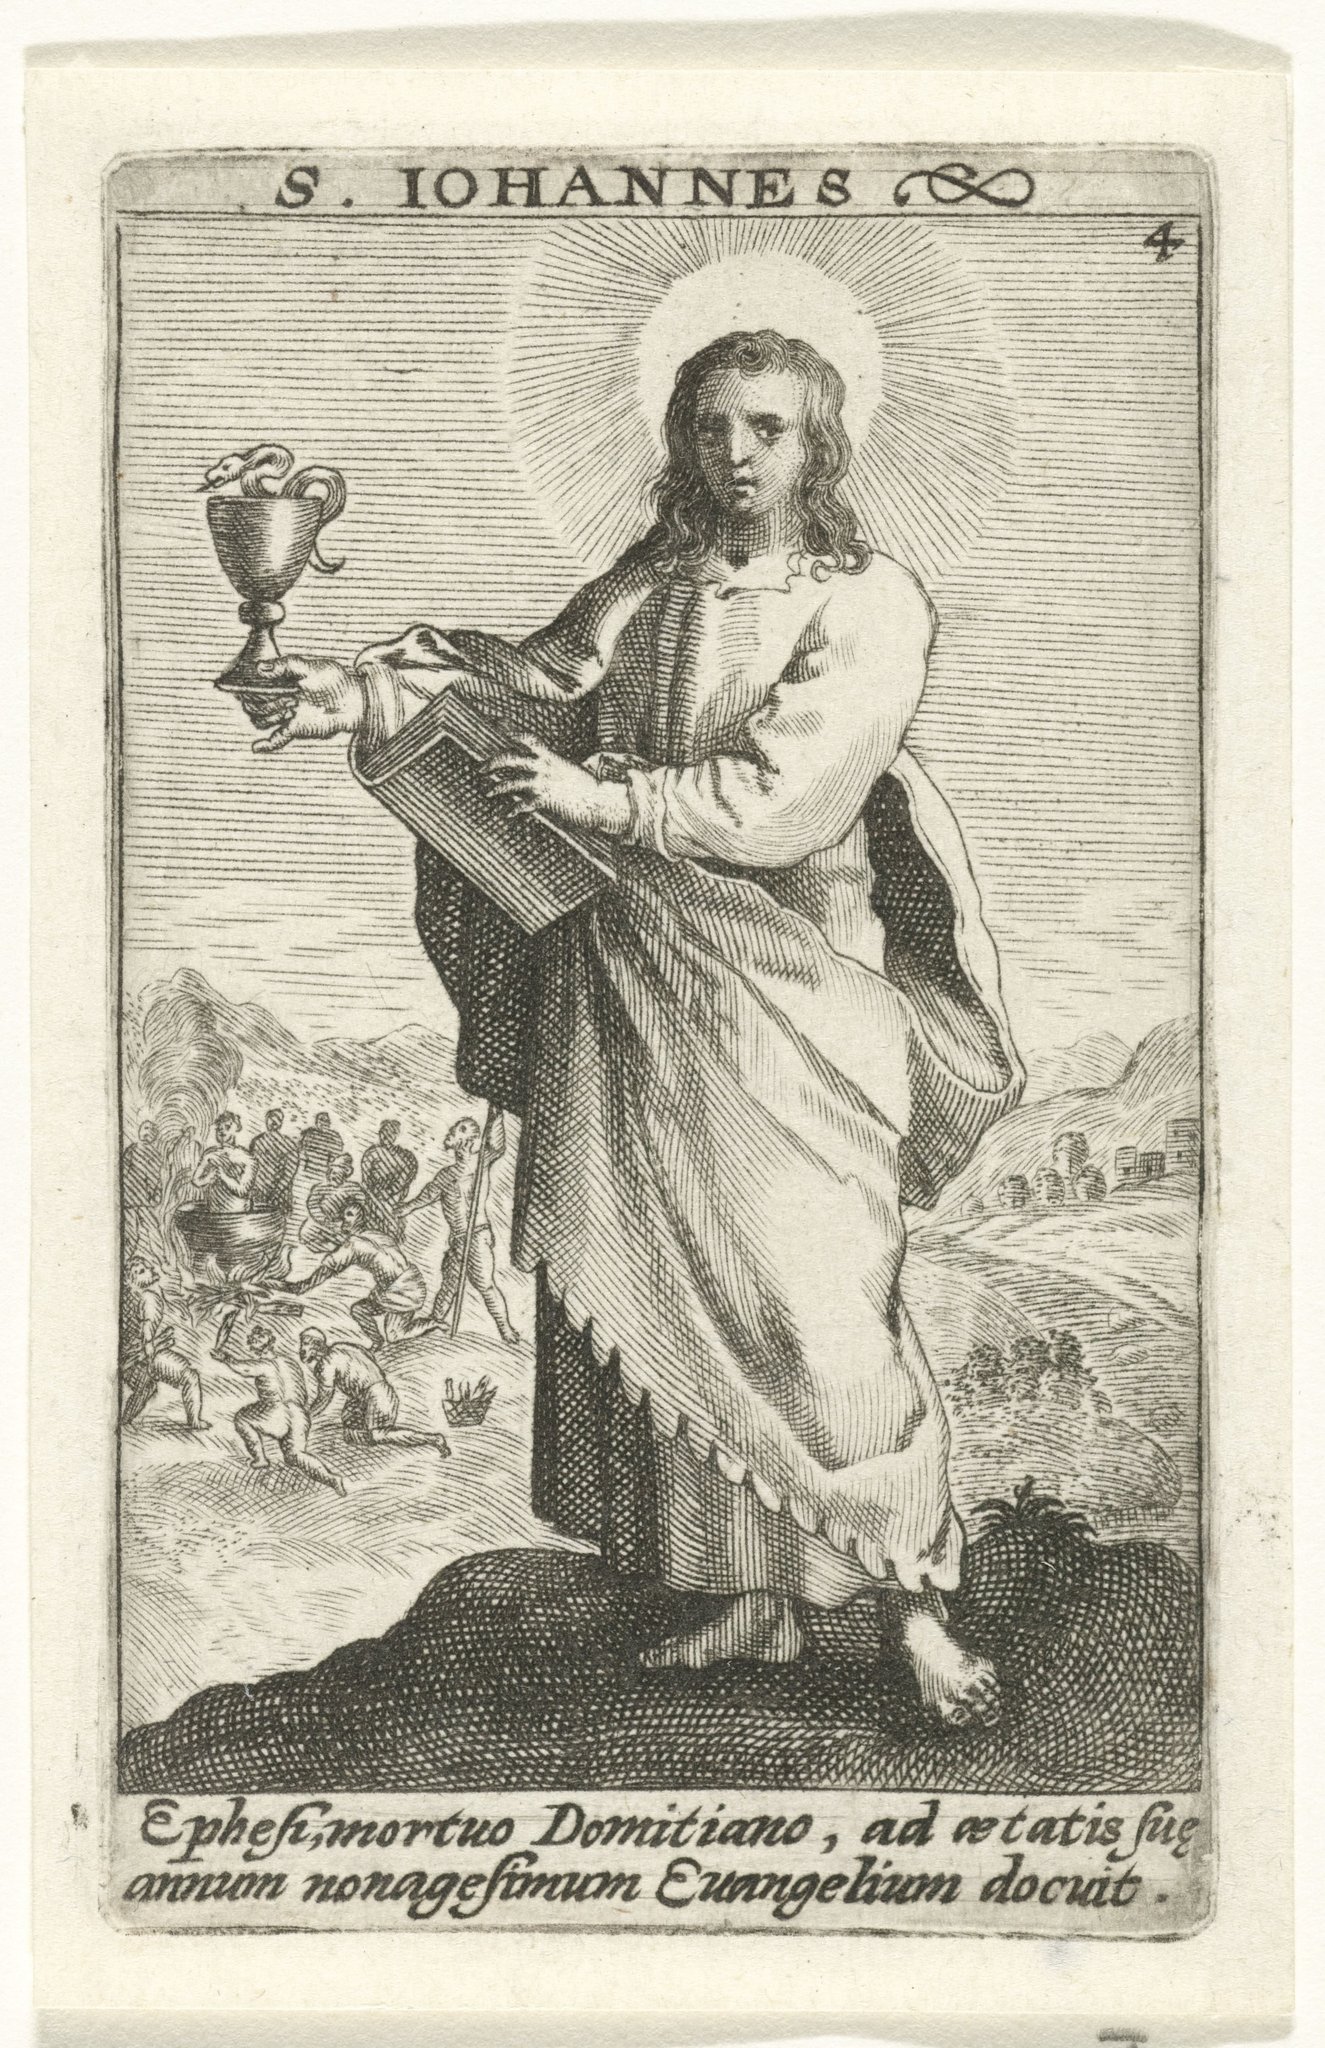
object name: print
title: De twaalf apostelen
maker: crispijn van de passe (i)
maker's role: draughtsman, print maker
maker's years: 1564-1637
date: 1574-1637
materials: paper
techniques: engraving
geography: cologne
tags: the apostle john the evangelist; possible attributes: book, cauldron, chalice with snake, eagle, palm, scroll, martyrdom of john in front of the porta latina: he is put in a cauldron of boiling oil, but remains unharmed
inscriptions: collector's mark: Lugt 240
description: De apostel Johannes, ten voeten uit, een kelk waaruit een slang verschijnt en een boek in zijn handen. Op de achtergrond de marteling van Johannes: hij wordt in een pot met kokende olie gestopt. In de marge een onderschrift in het Latijn. Prent uit een serie met de twaalf apostelen.